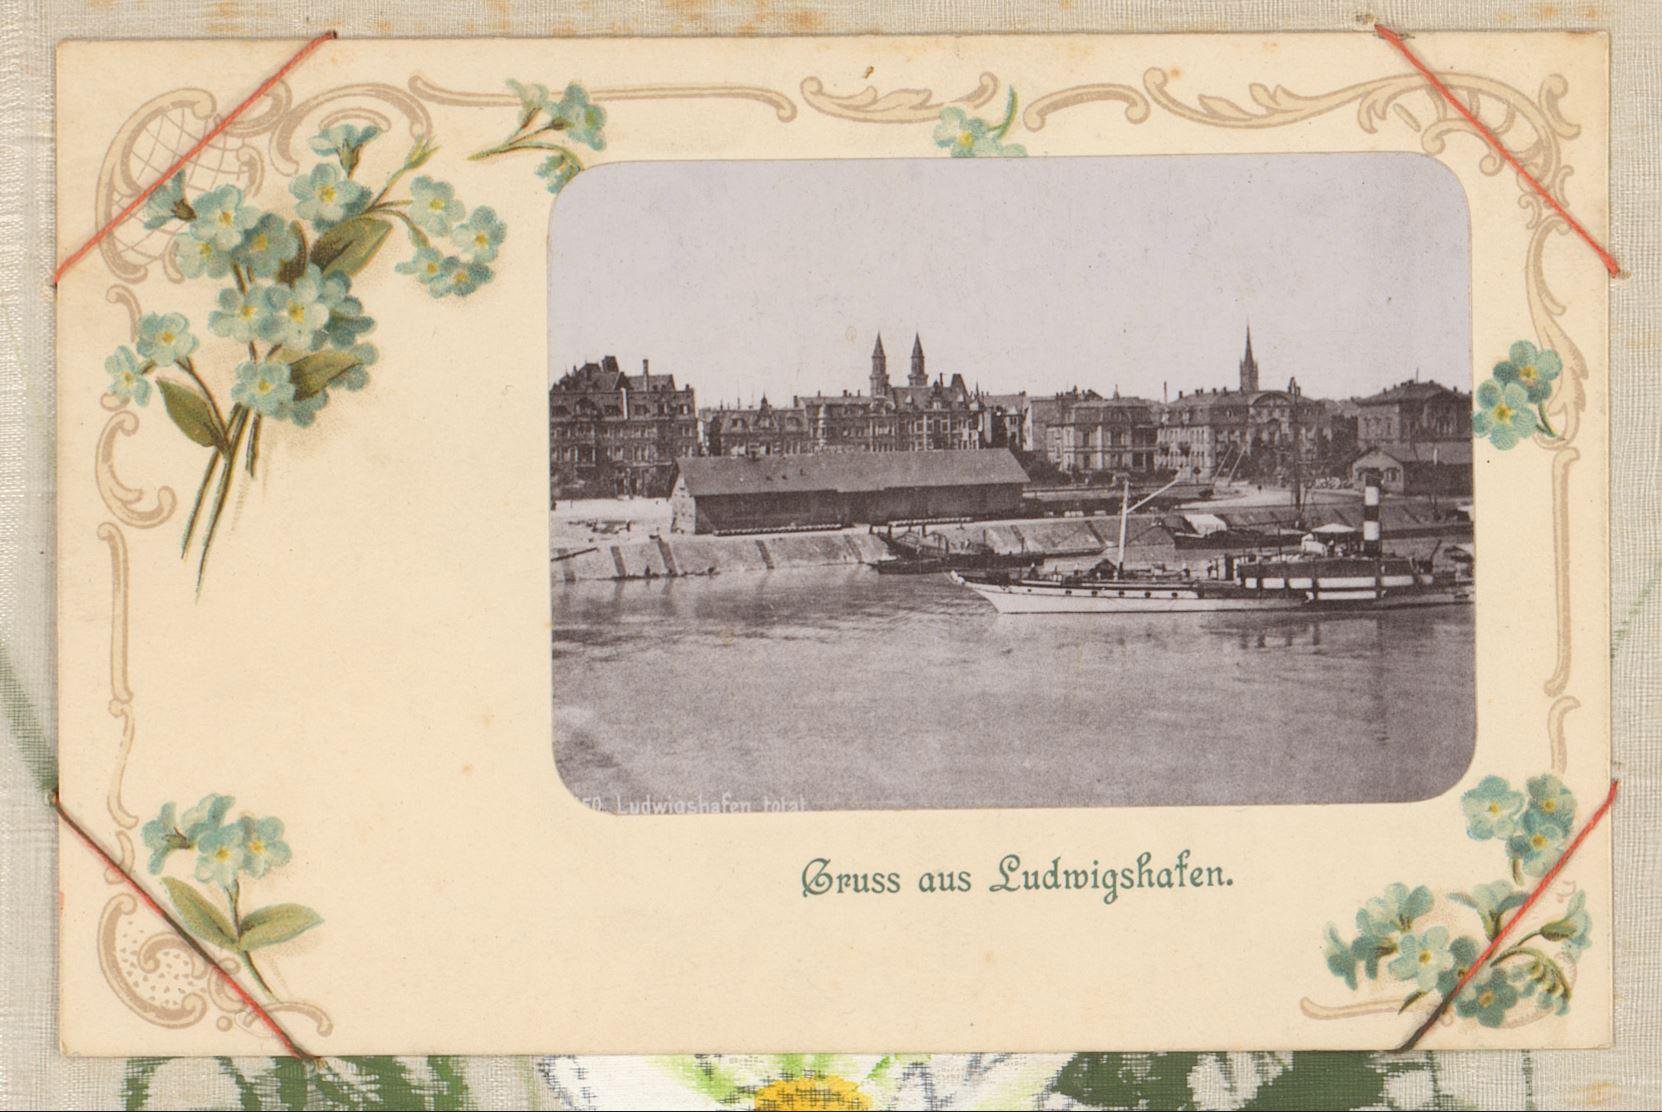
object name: ansichtkaart, prentbriefkaart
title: Ludwigshafen total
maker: Anonymous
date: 1880-1910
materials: cardboard, paint, paper, silk, textile, watercolor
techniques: brush, chromolithography, photograph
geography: ludwigshafen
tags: city-view in general; 'veduta', ships (in general)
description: Deze prent maakt deel uit van een album.